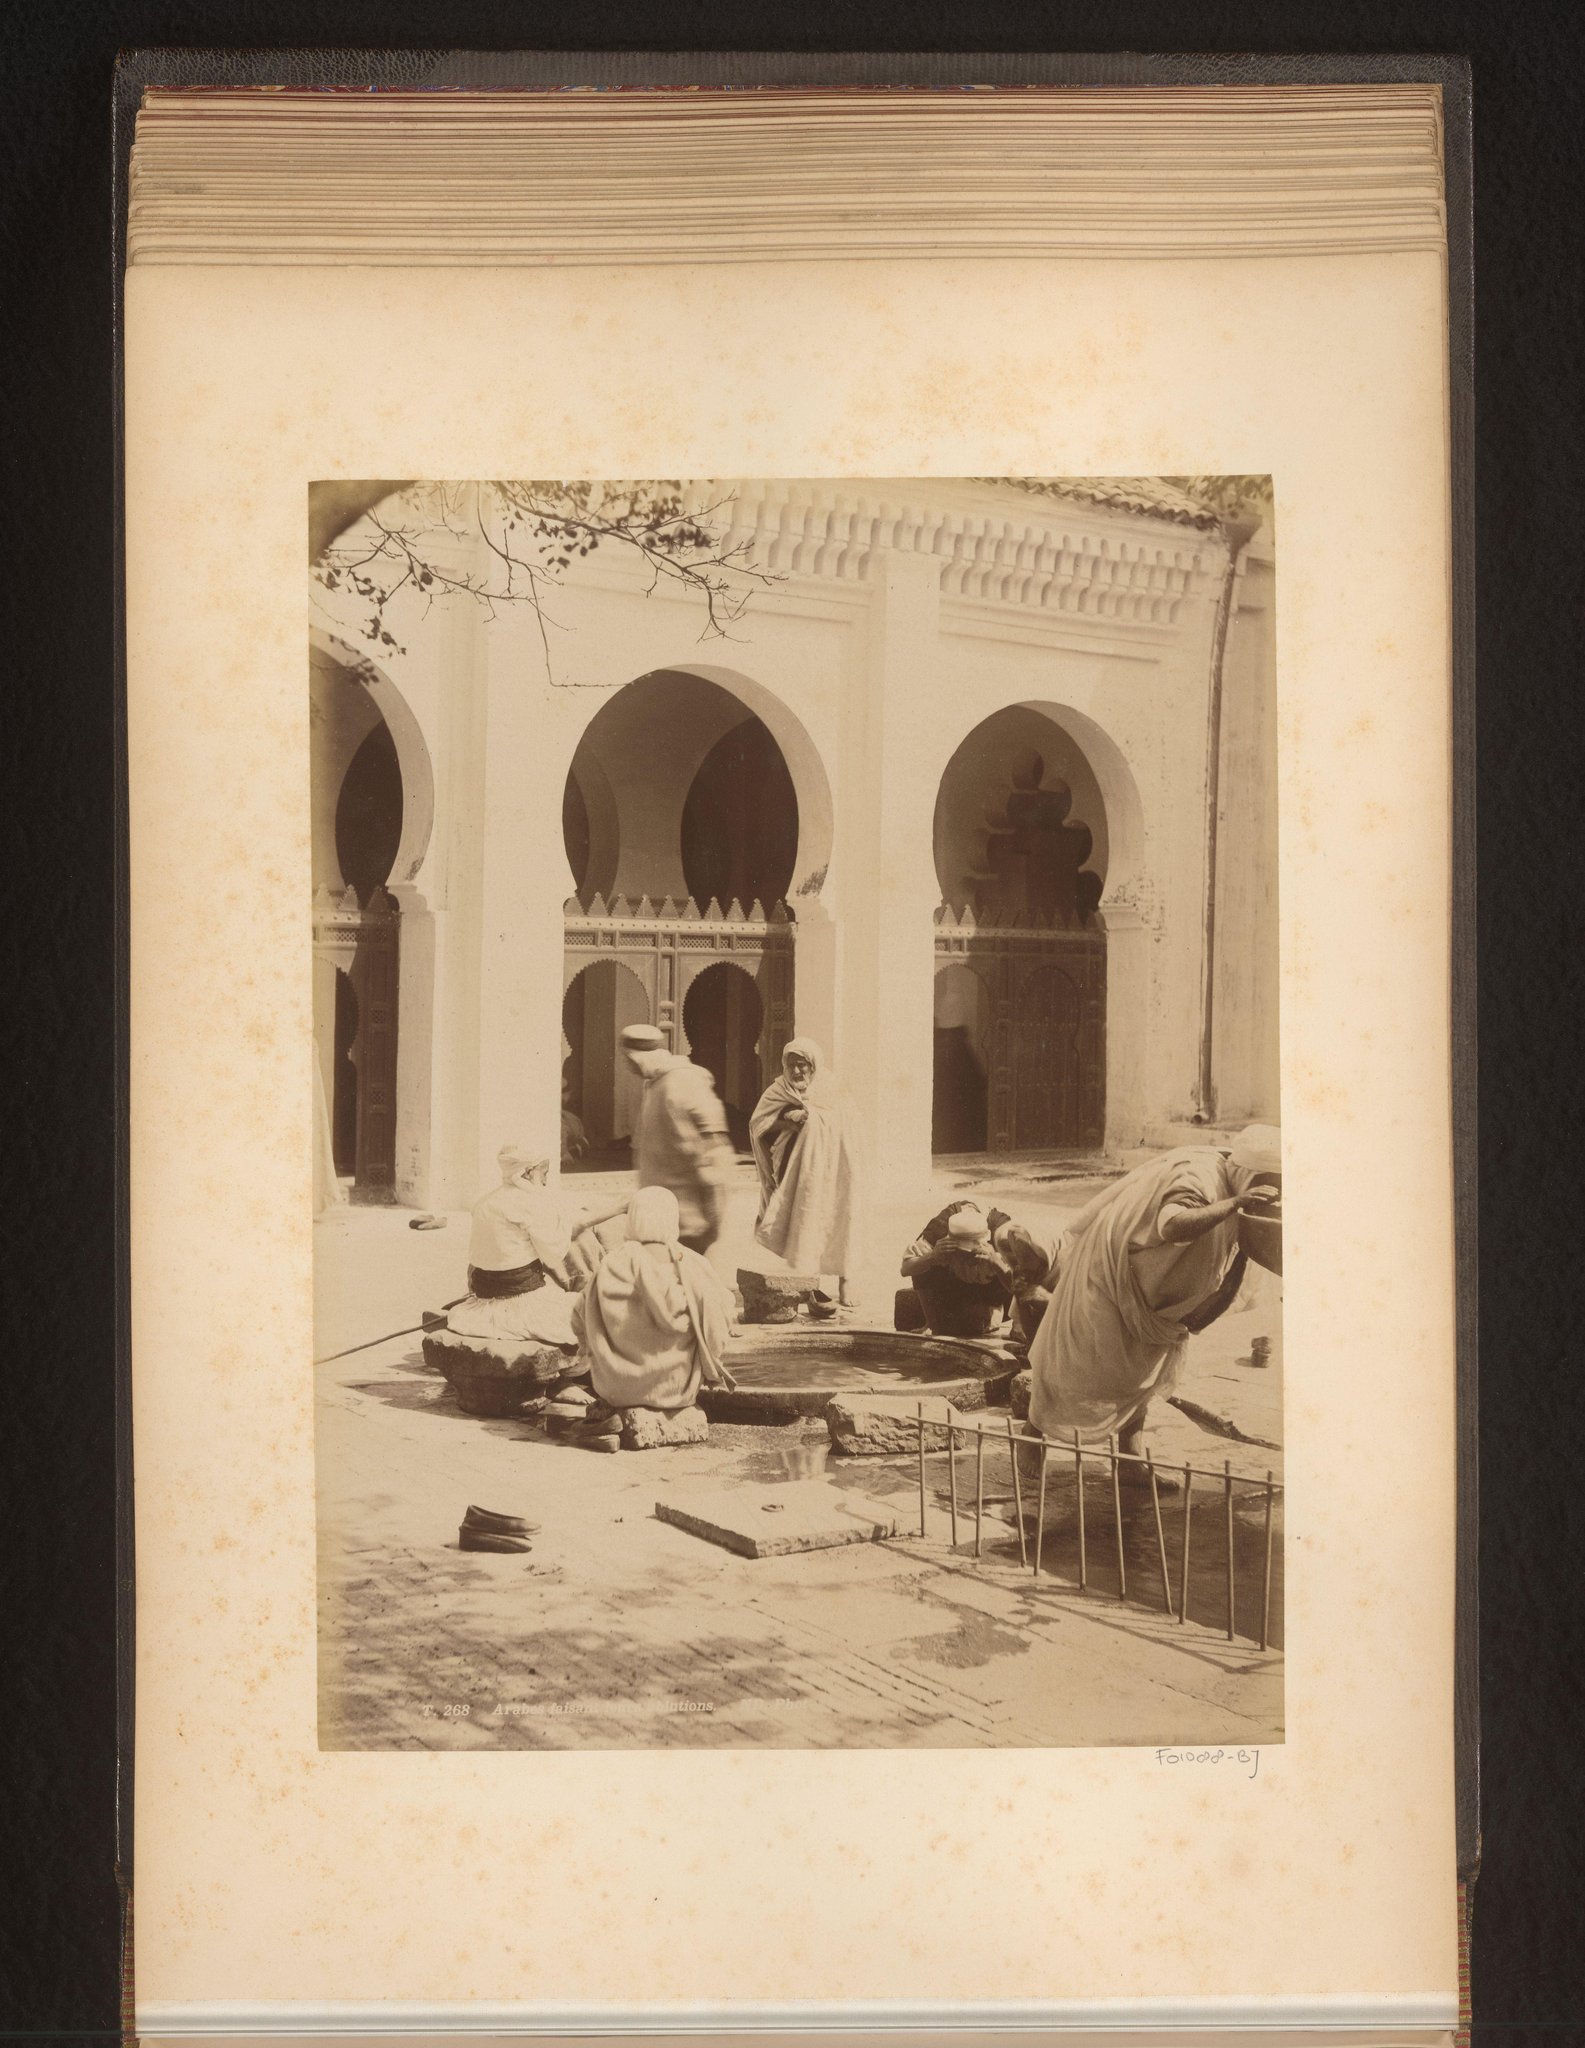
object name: album leaf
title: Mannen wassen het gezicht of drinken op een binnenplaats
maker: étienne neurdein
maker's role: publisher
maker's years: 1832-1918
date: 1880-1900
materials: photographic support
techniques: albumen print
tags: adult man, historical persons, courtyard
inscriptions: number: ‘T. 268’